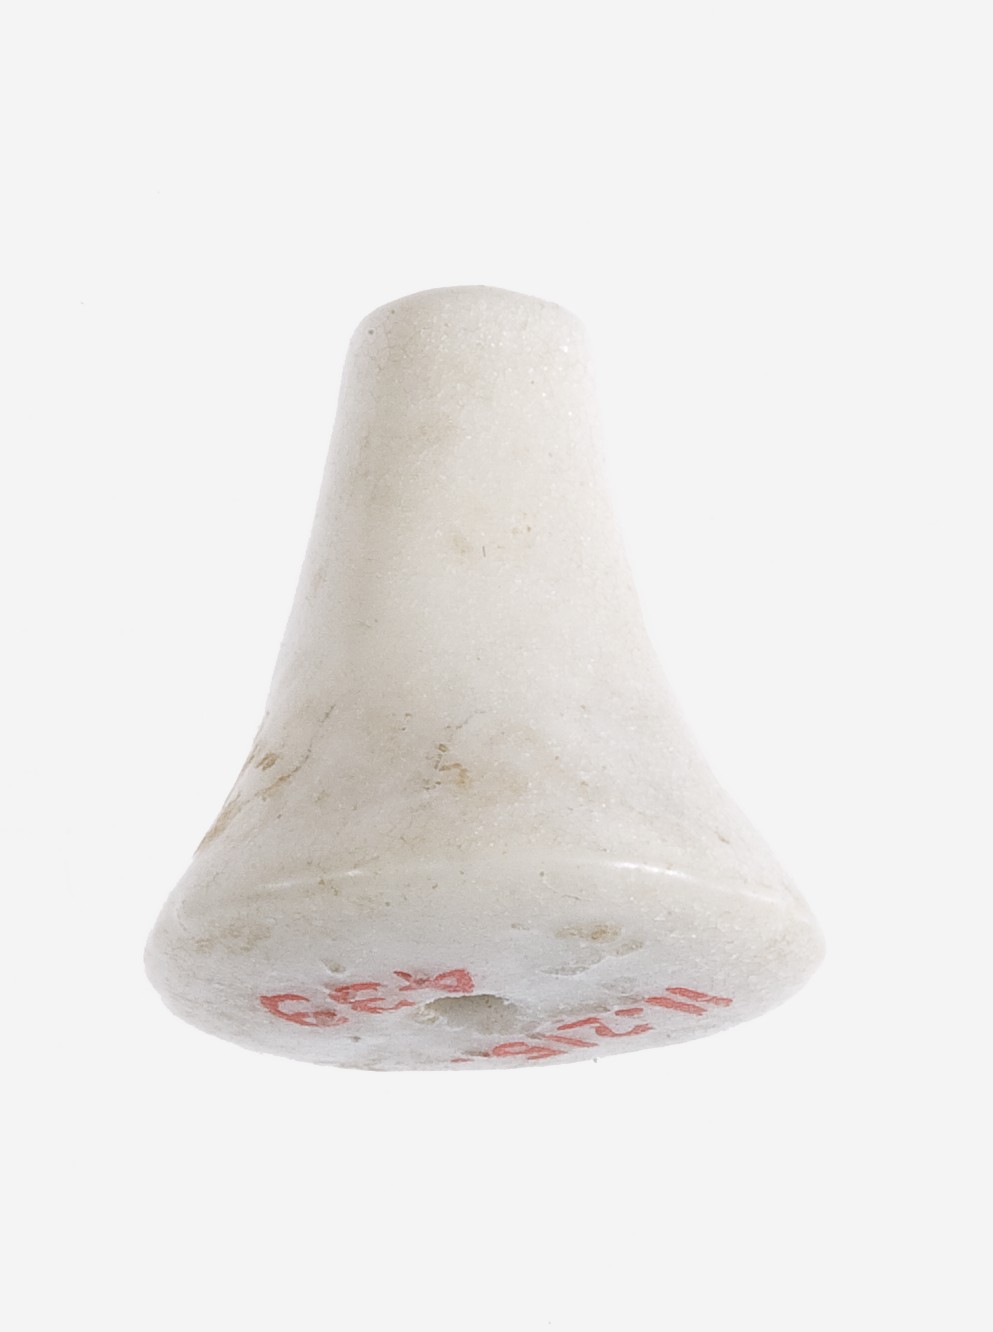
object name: pendant, umbel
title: Umbel Pendant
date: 1390-1352 BCE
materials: faience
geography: egypt